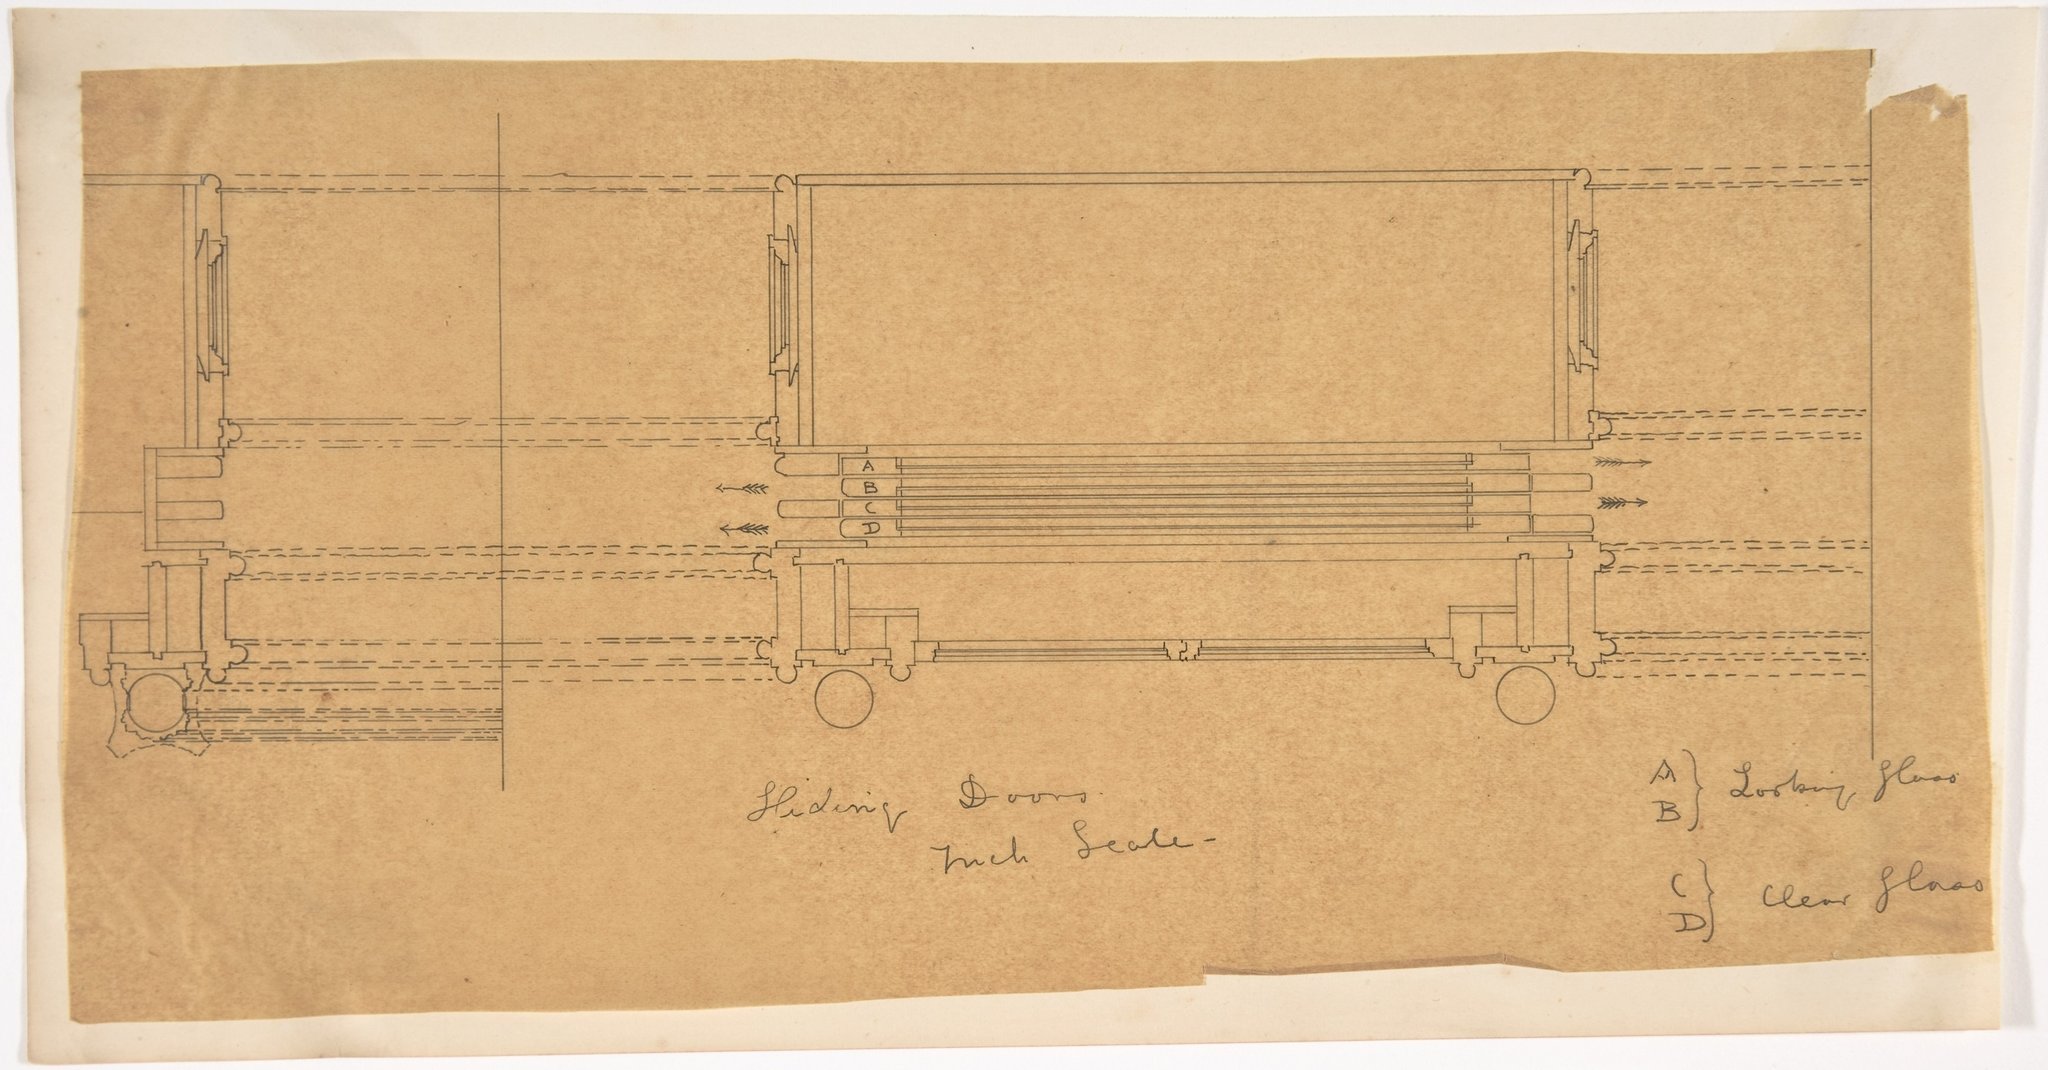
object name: drawing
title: Design for Sliding Doors and Mirrors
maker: anonymous, british, 19th century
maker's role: artist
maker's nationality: british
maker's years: 1800-1900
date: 1801-1900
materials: ink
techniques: pen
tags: architecture